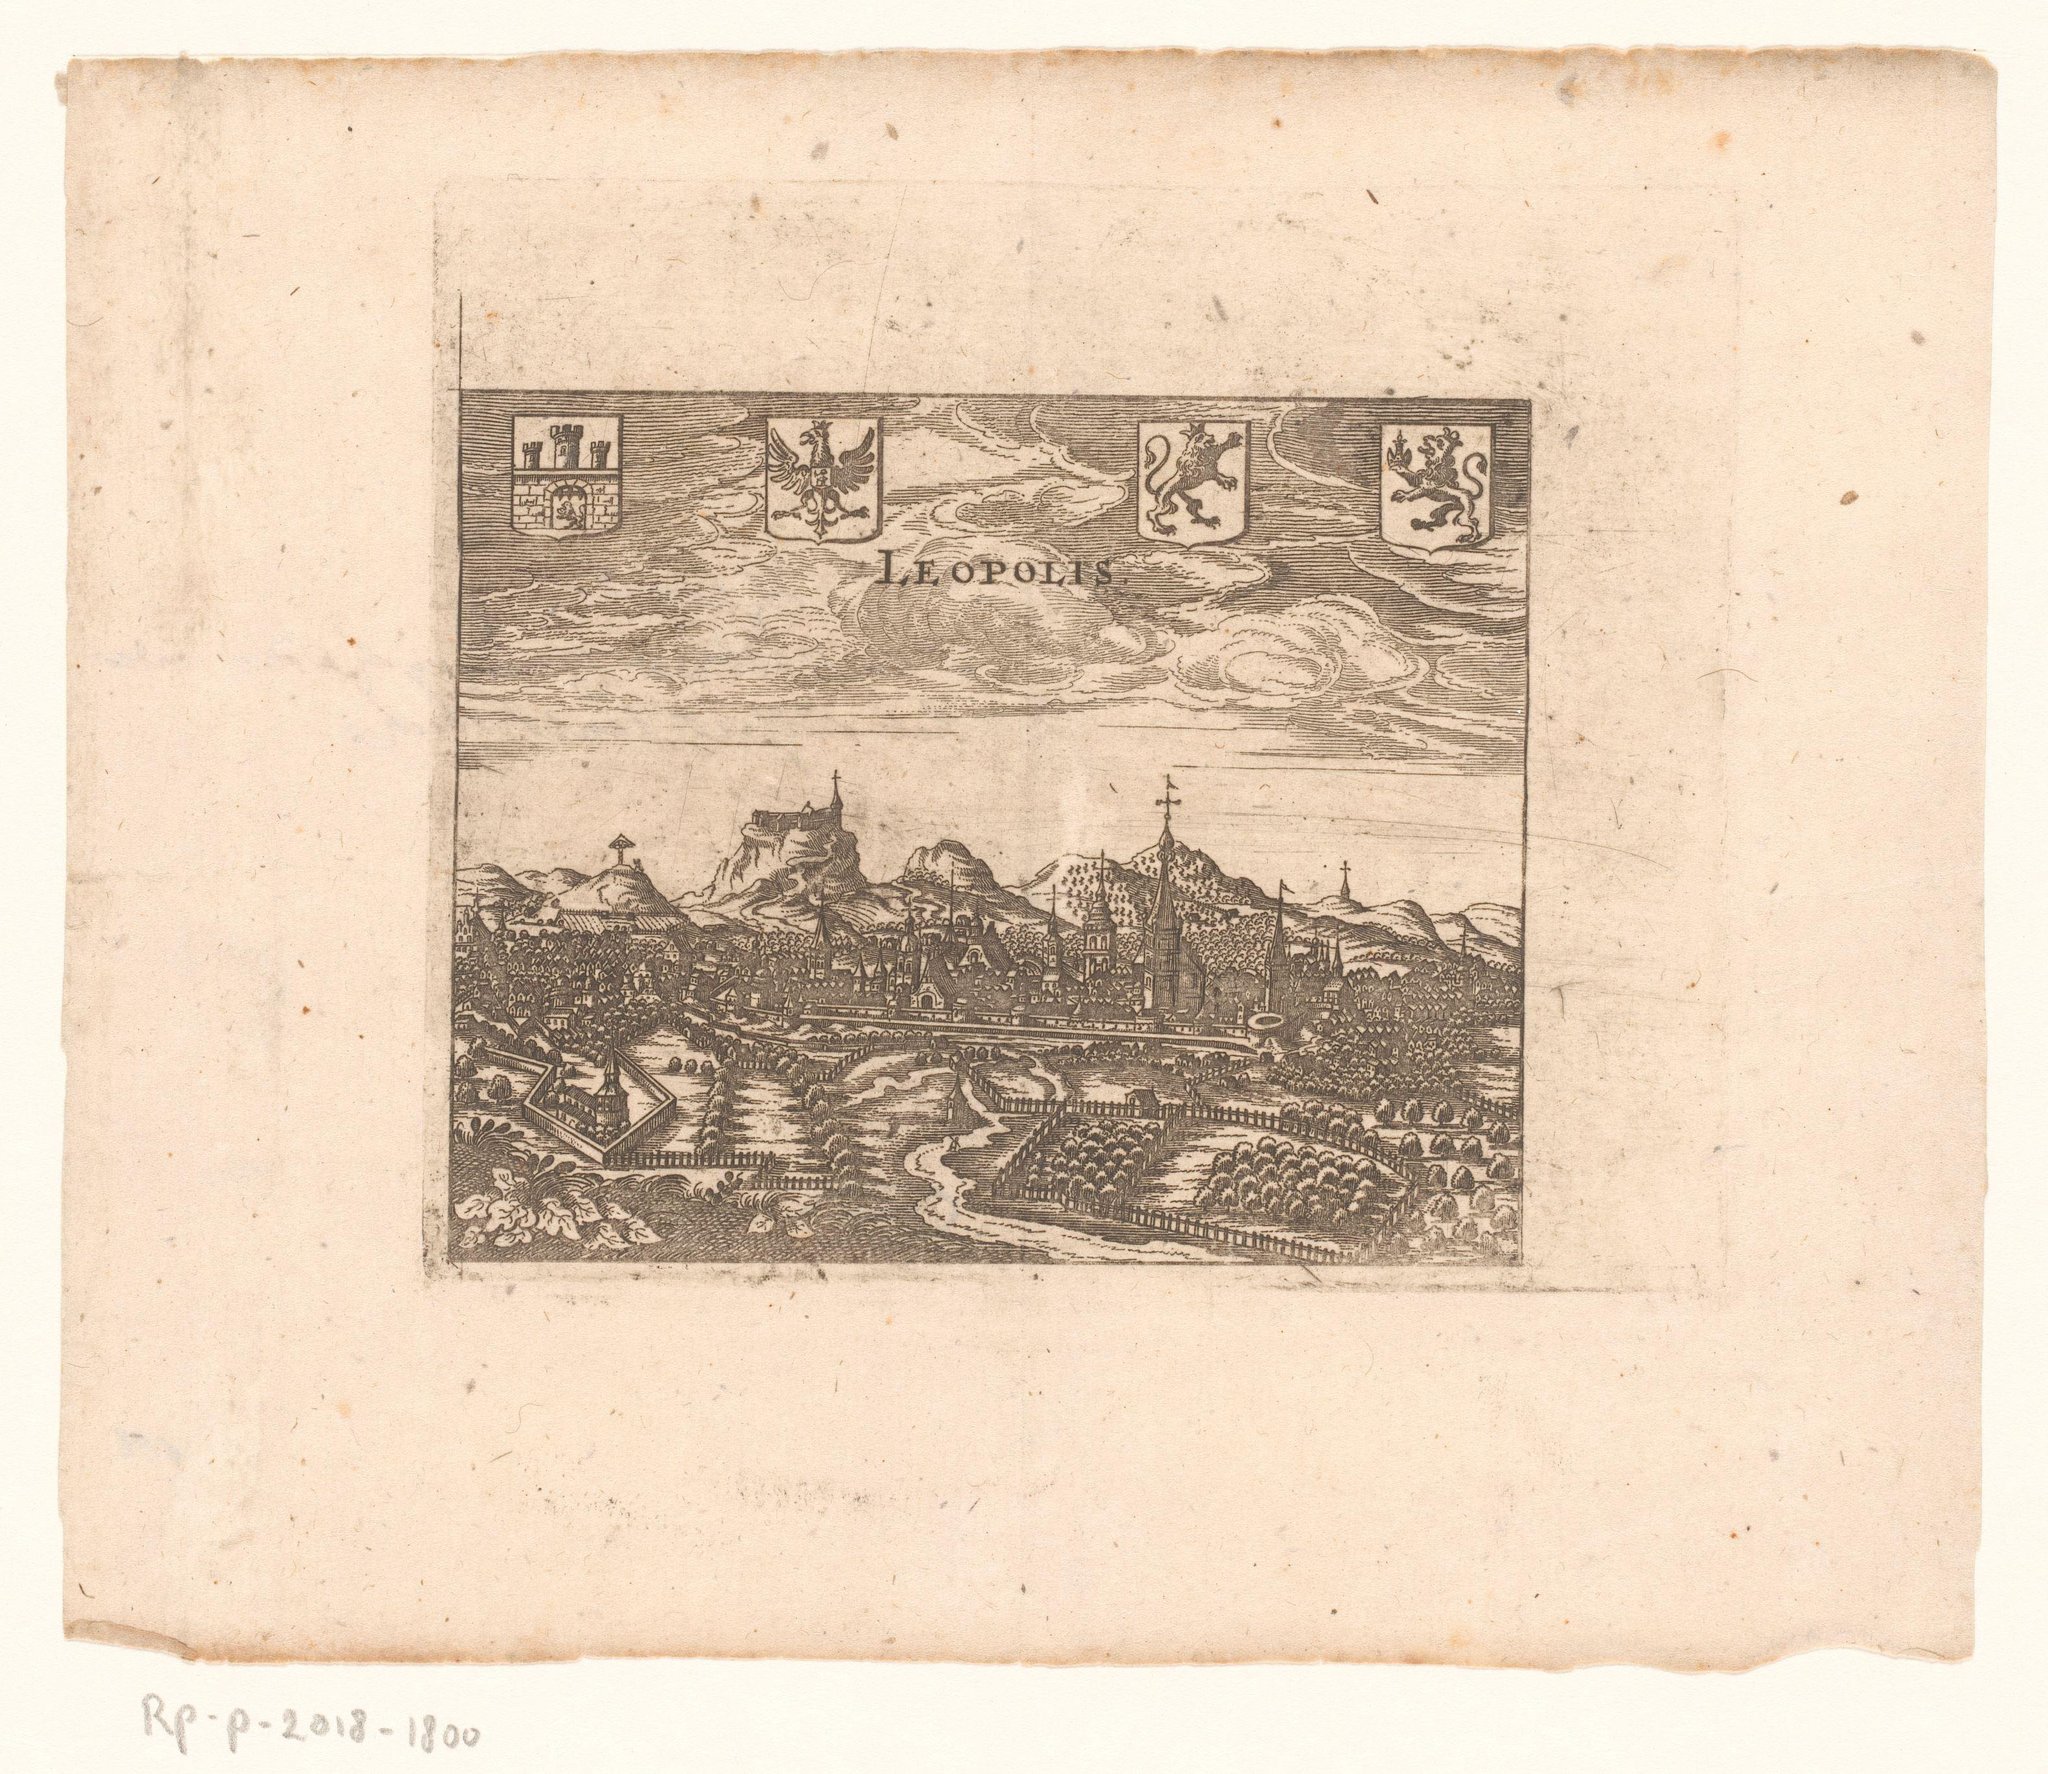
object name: print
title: Gezicht op Lviv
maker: Anonymous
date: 1650-1749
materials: paper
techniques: etching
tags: coat of arms (as symbol of the state, etc.) (+ city; municipal), coat of arms (as symbol of the state, etc.) (+ province; provincial), prospect of city, town panorama, silhouette of city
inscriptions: collector's mark: Lugt 2228